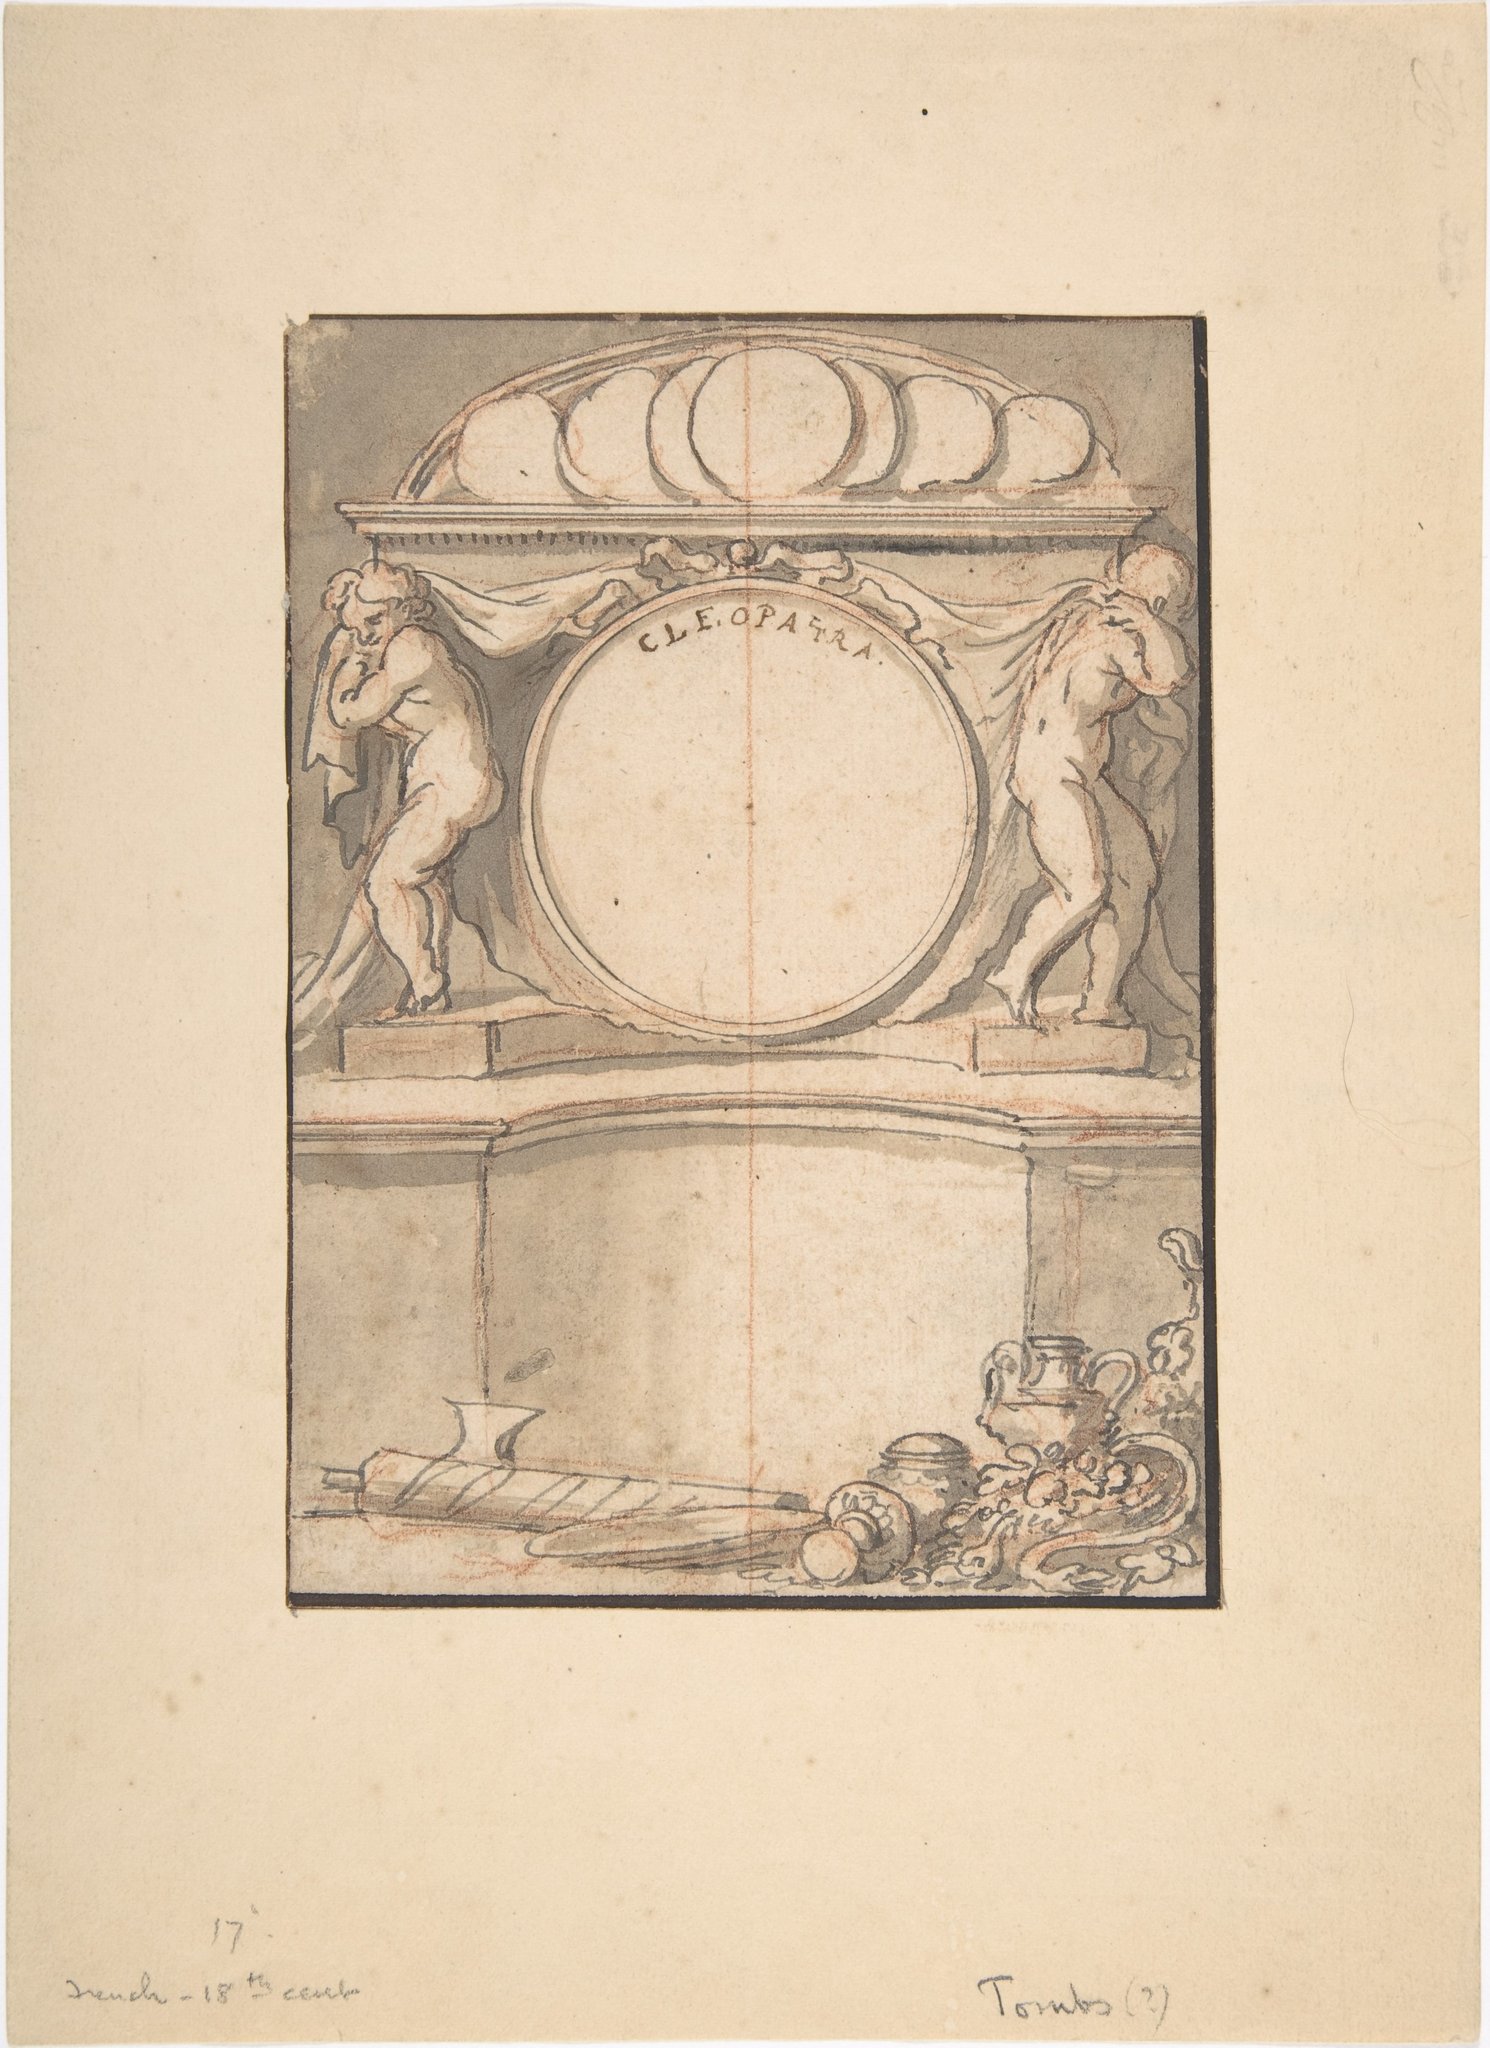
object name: drawing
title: Drawing for a Book Illustration: Cleopatra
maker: anonymous, french, 18th century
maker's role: artist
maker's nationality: french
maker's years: 1700-1800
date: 1701-1800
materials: chalk, ink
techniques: brush, pen, wash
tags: cleopatra